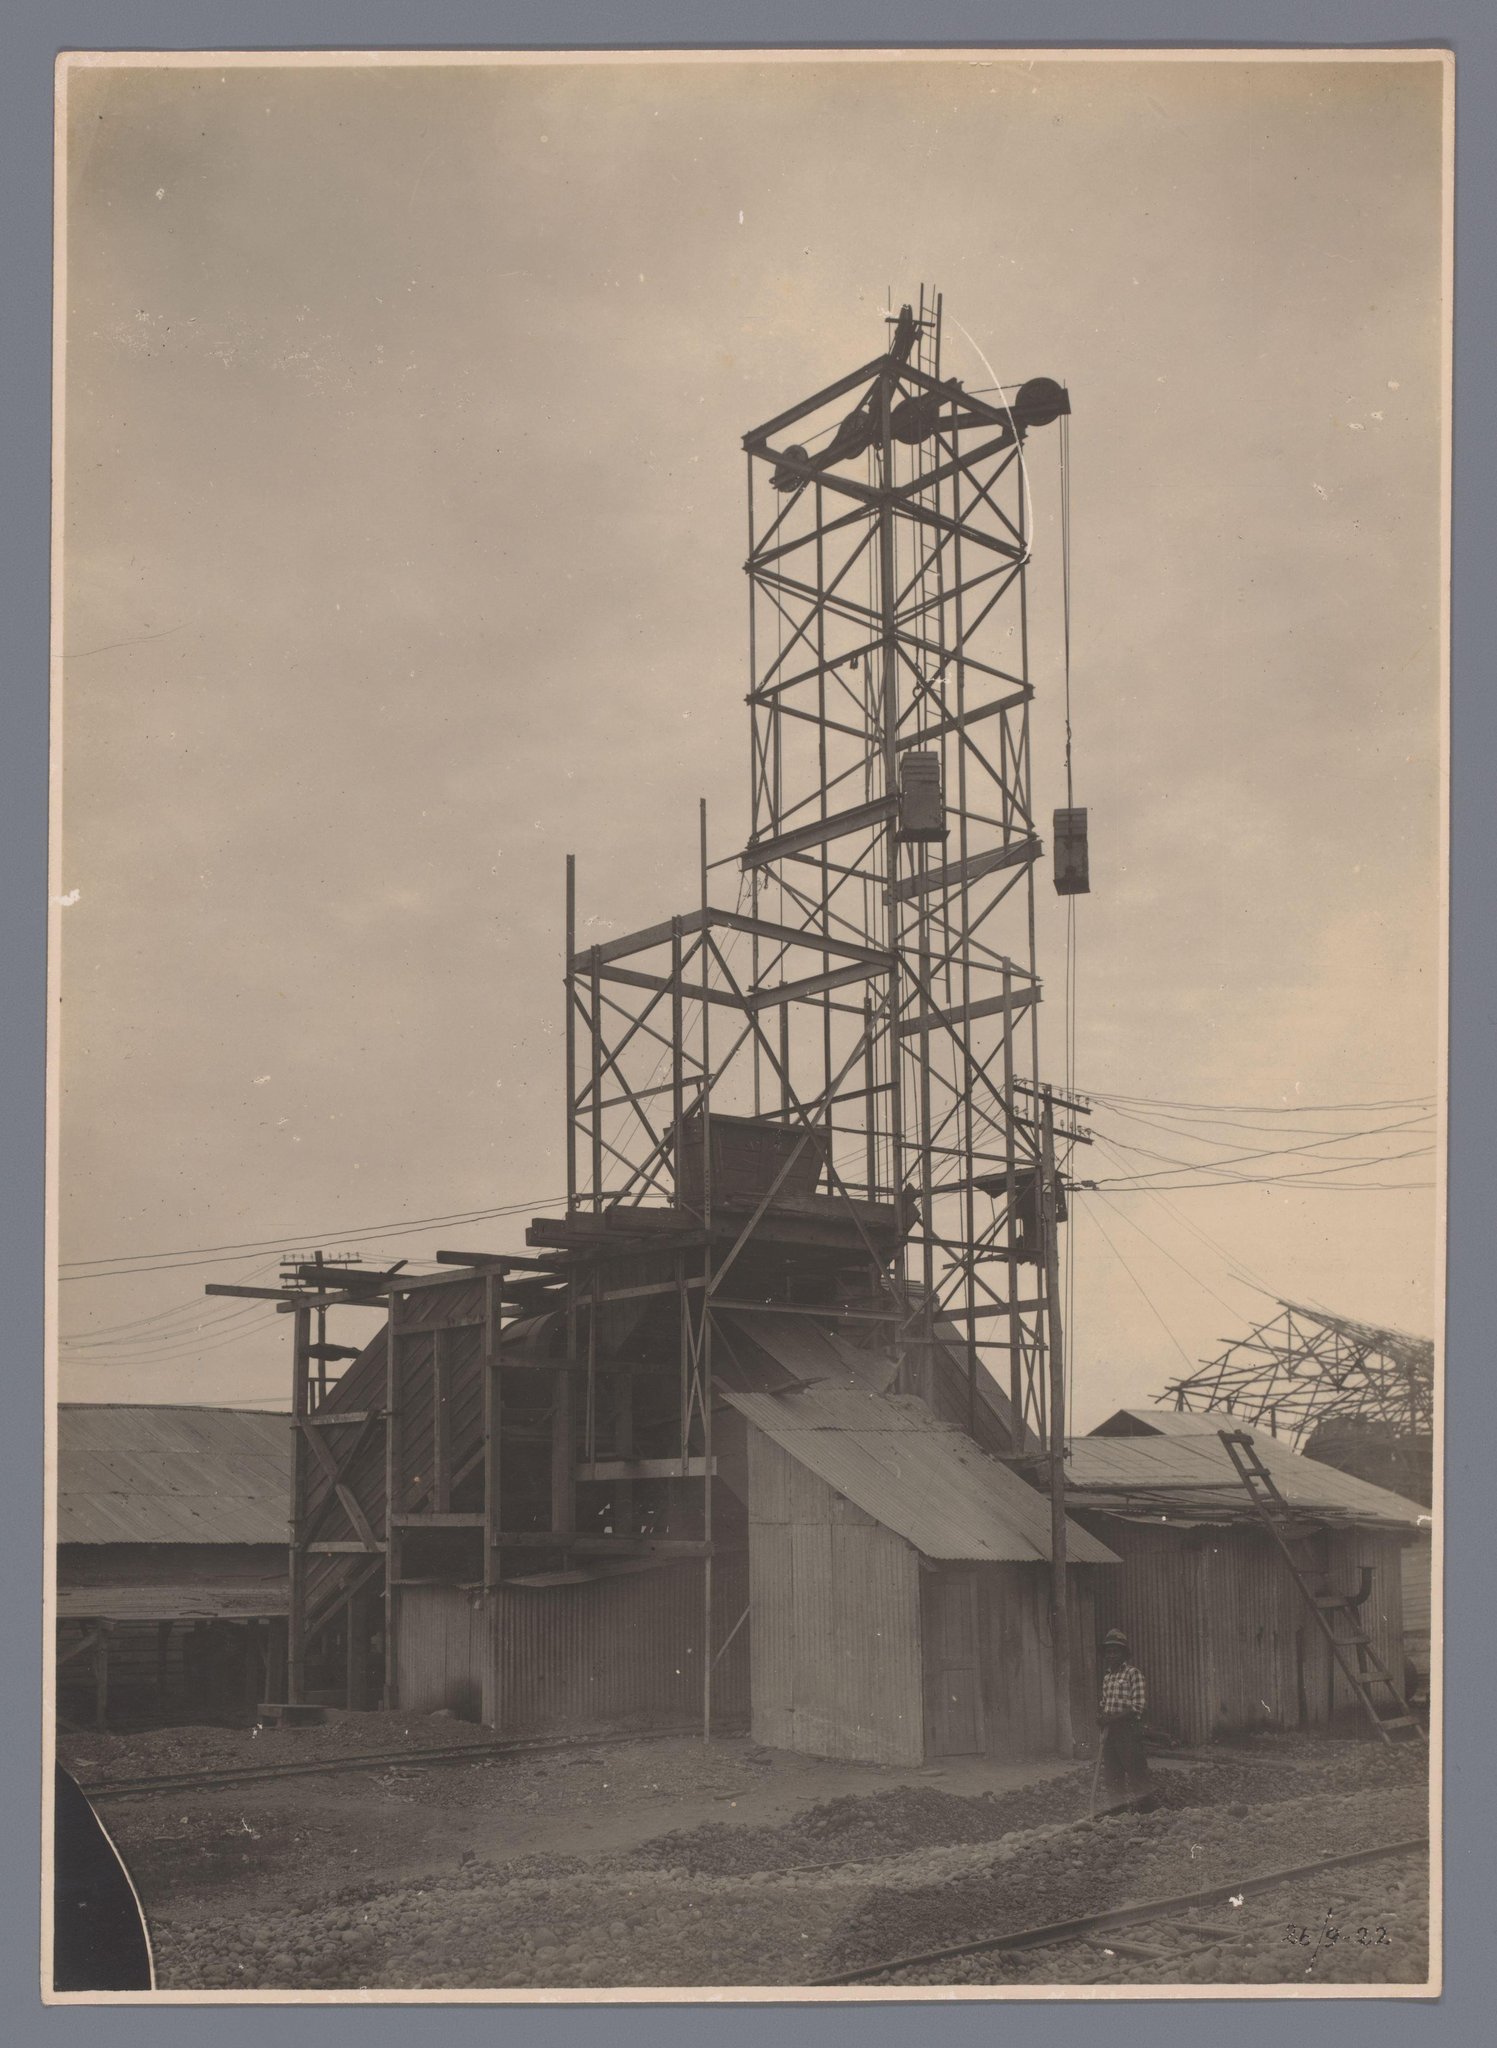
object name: photograph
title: Lift en steenbreker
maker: Anonymous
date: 1922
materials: photographic support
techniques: gelatin silver print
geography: belawan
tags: harbour, machines; parts of machines; tools and appliances, building-site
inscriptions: date: ‘26/9-22’, inscription: ‘No. 219 Lift en steenbreker’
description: Houten stellage met lift. Genummerd: 219. Onderdeel van de groep van losse foto's over de aanleg van de haven Belawan aan de kust voor Medan, Sumatra 1921-1922.